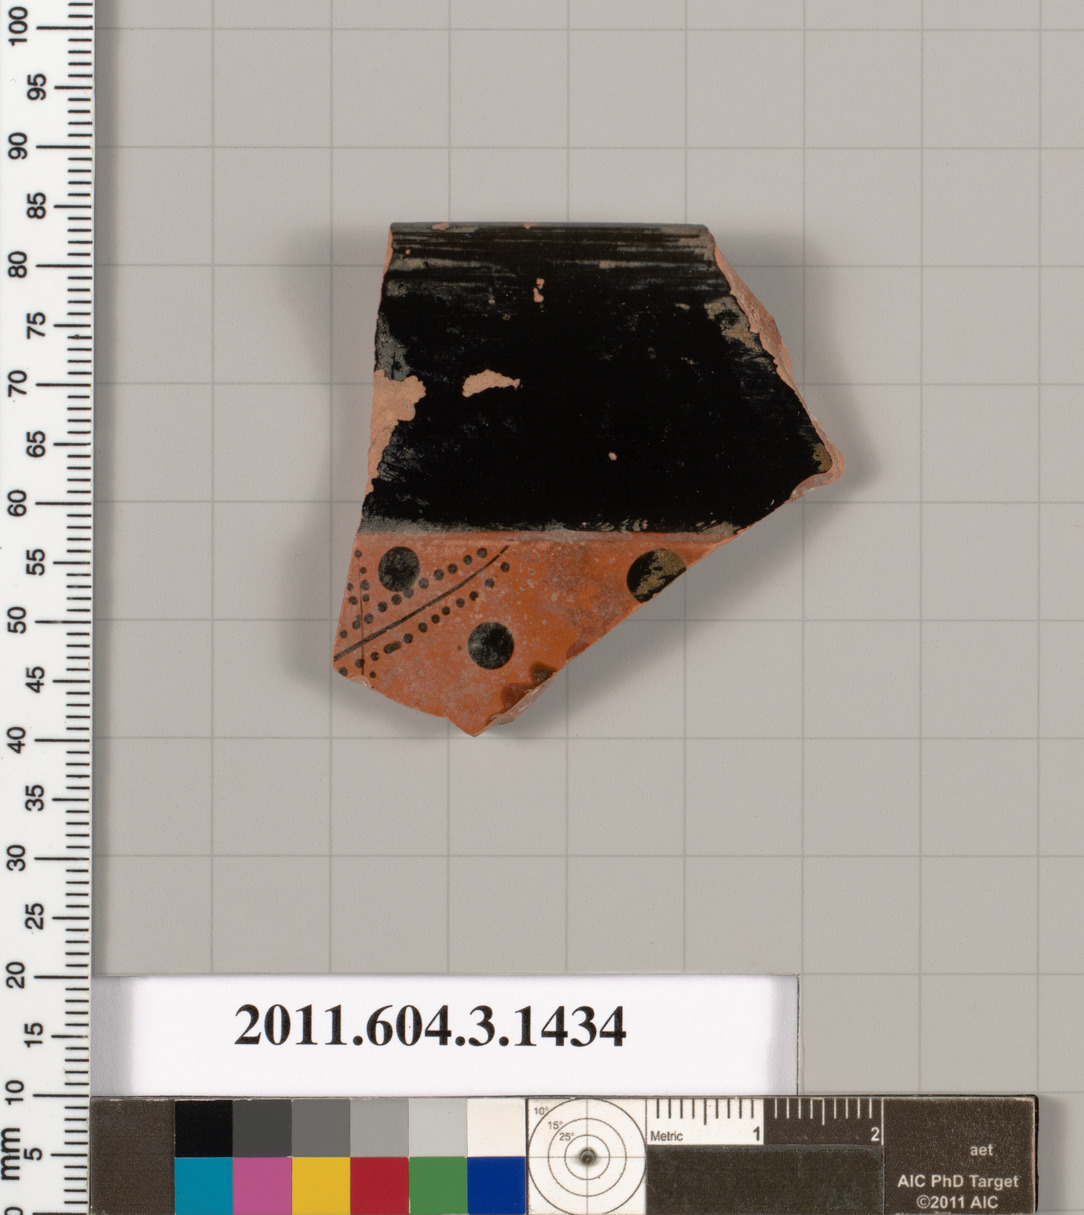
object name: skyphos fragment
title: Terracotta rim fragment of a skyphos (deep drinking cup)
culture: greek, attic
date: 534-468 BCE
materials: terracotta